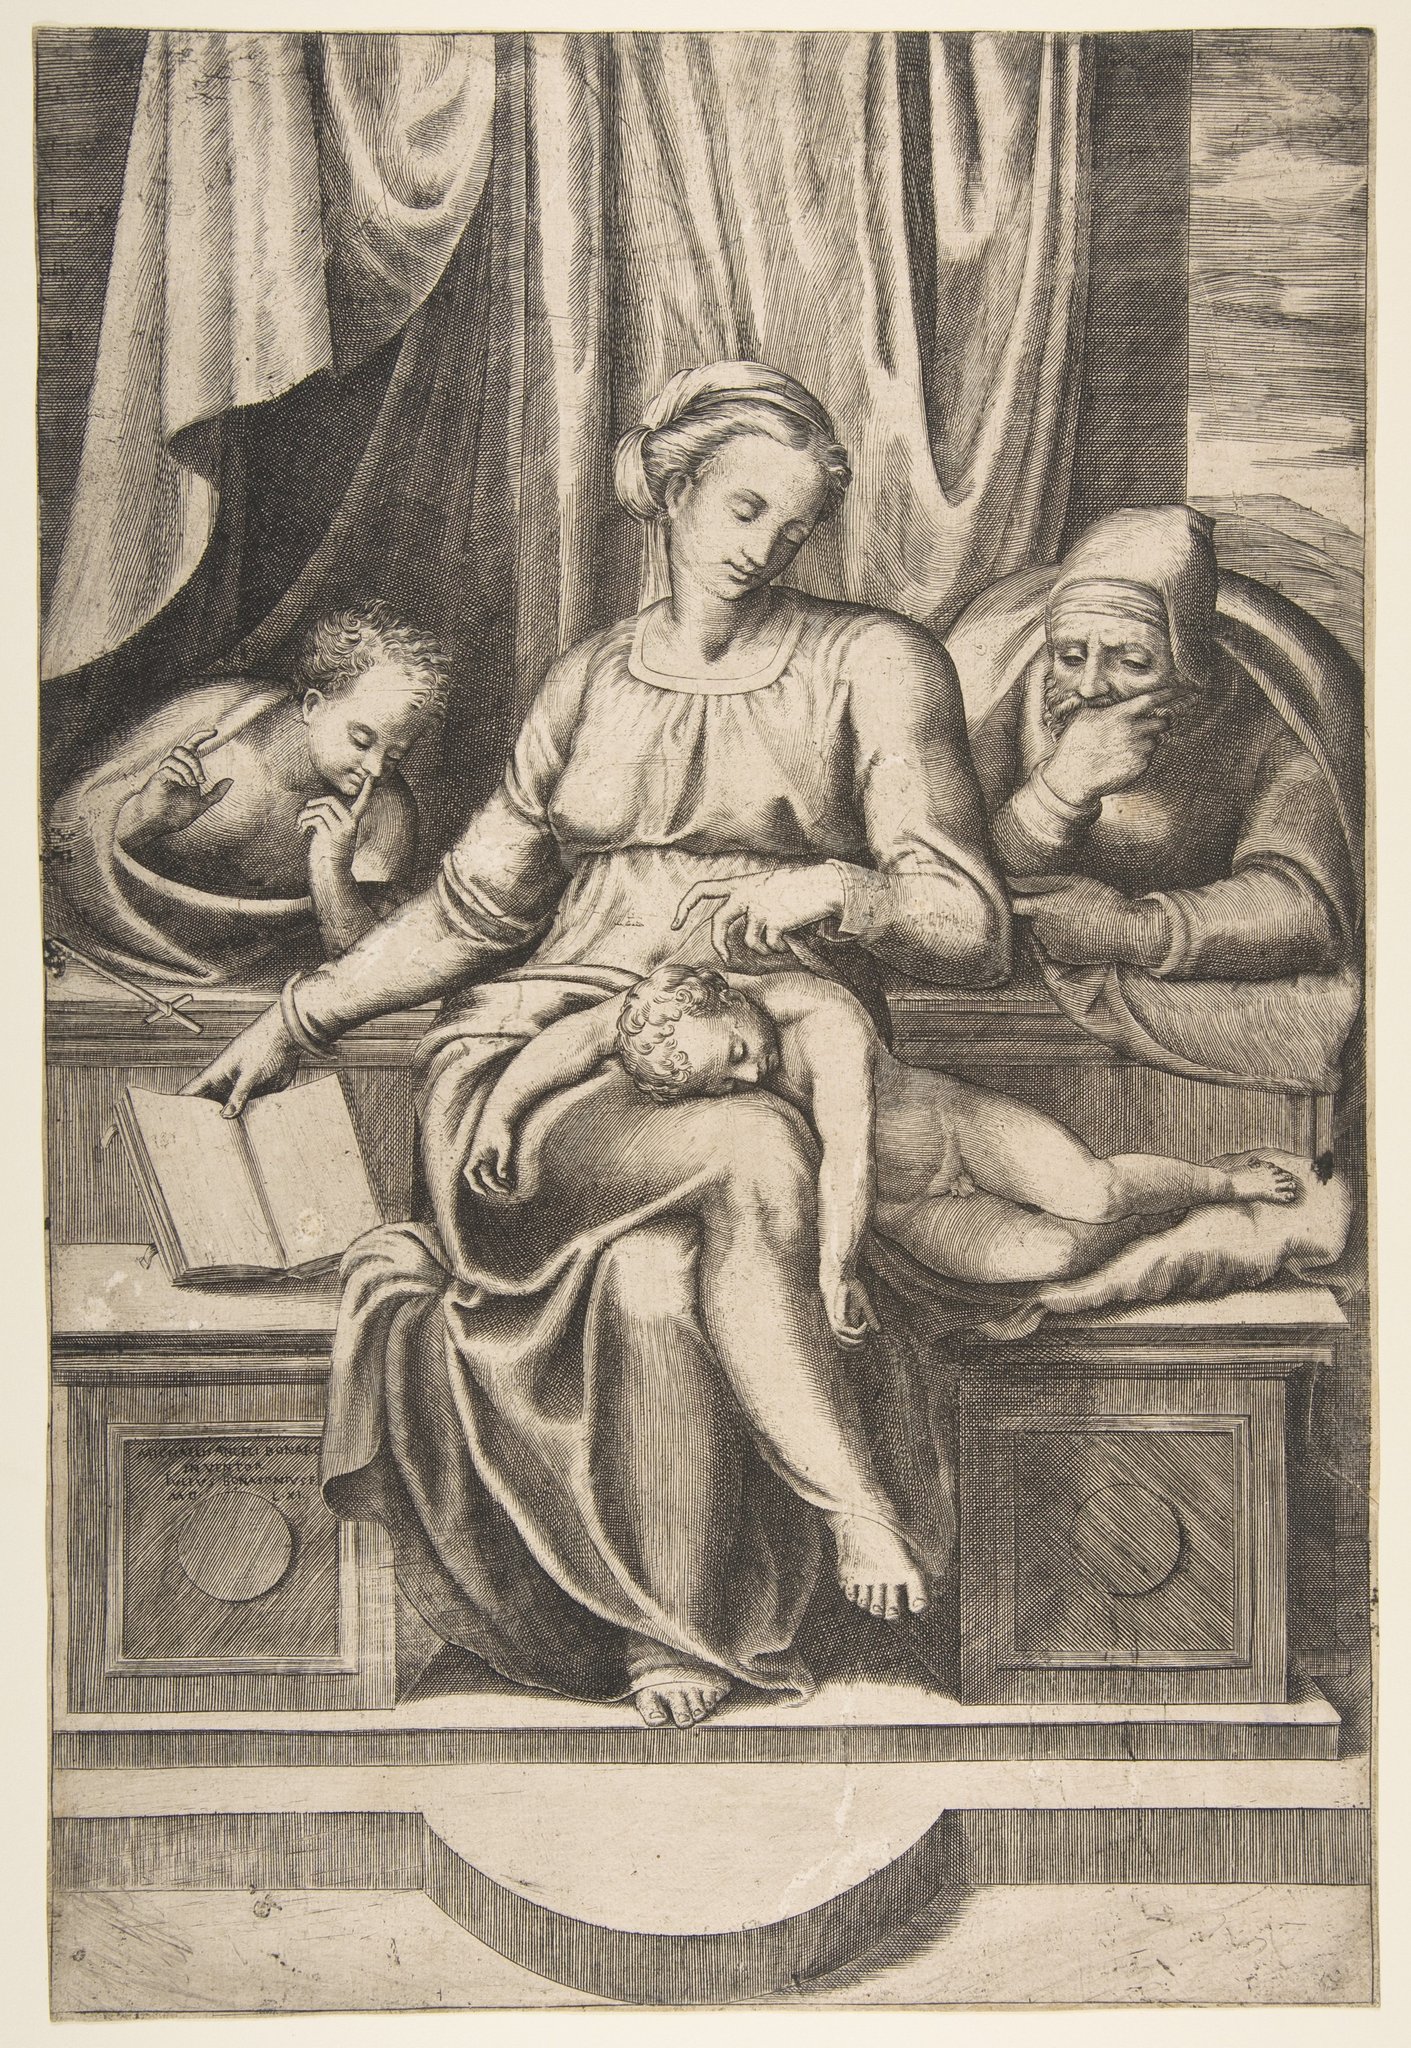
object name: print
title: Virgin and Child with Saints Joseph and John the Baptist (after Michelangelo's Madonna del Silenzio)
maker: giulio bonasone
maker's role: artist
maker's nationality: italian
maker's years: 1510-1576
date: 1561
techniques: engraving, etching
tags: sleeping,christ,saint john the baptist,saint joseph,virgin mary